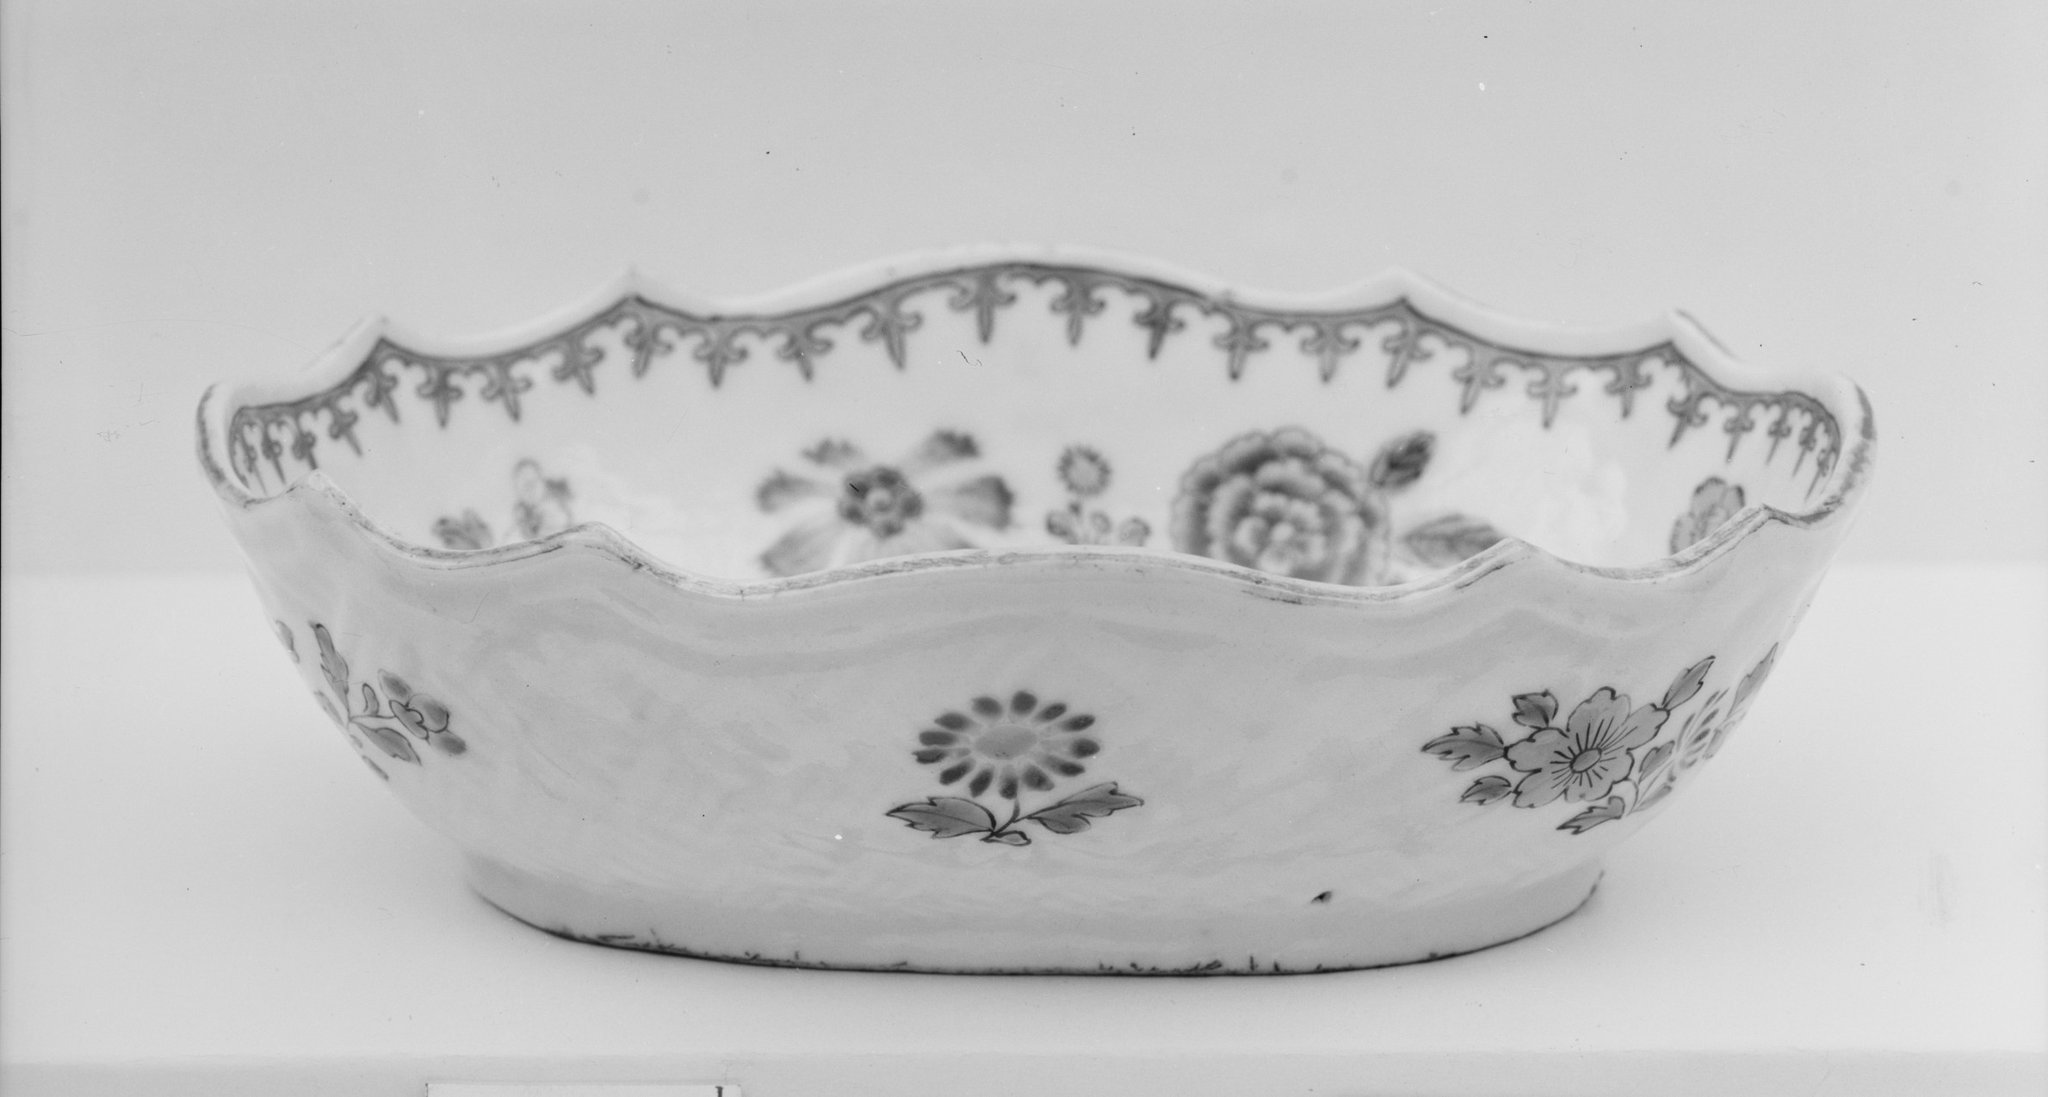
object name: dish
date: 1736-1795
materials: porcelain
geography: china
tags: flowers